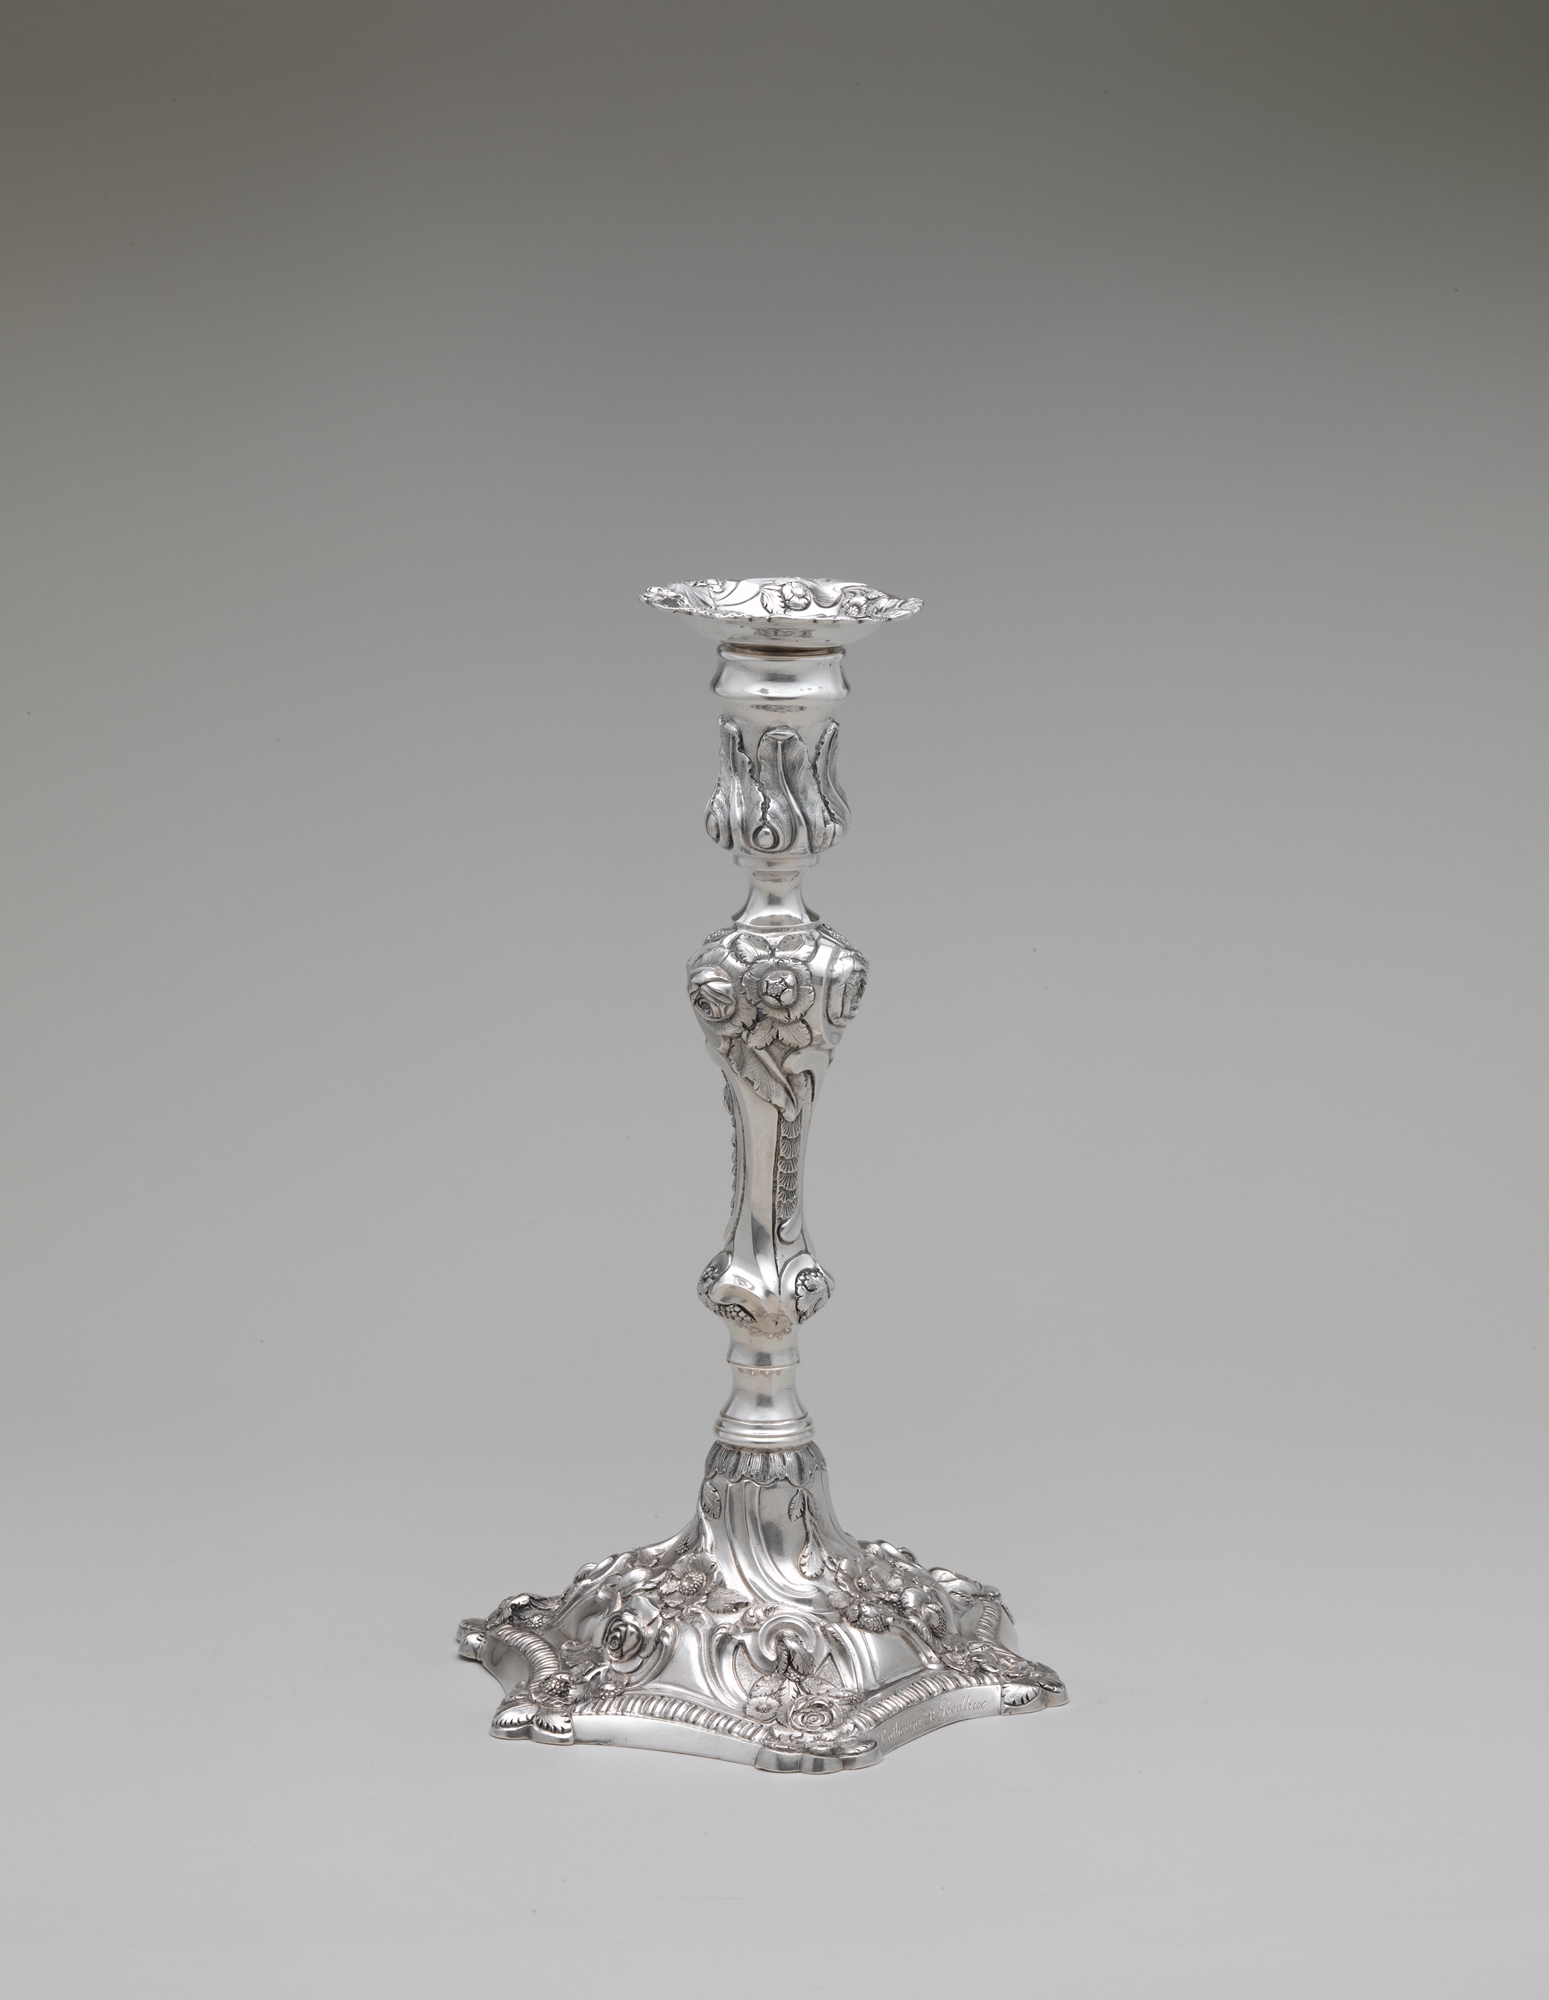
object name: candlestick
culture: american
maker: william thomson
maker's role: maker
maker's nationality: american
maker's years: 1777-1833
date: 1825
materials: silver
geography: united states